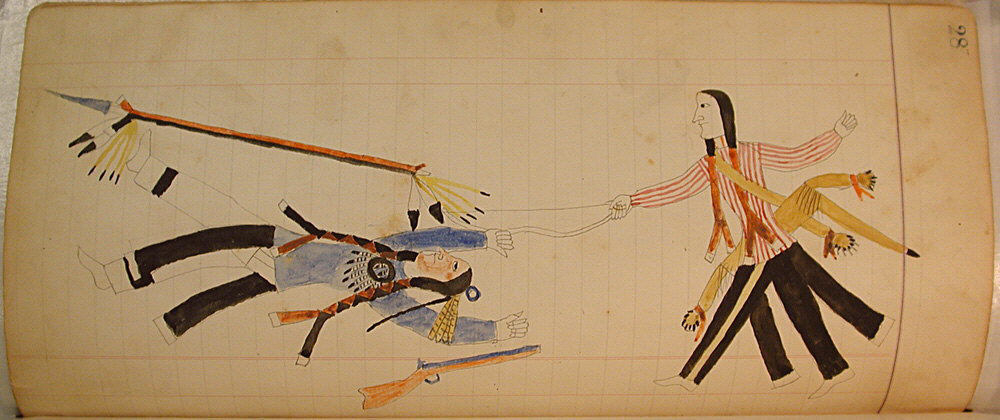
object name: drawing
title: Maffet Ledger: Two indians, multiple legs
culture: cheyenne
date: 1874-1881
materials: crayon, graphite, paper, watercolor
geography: united states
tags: men